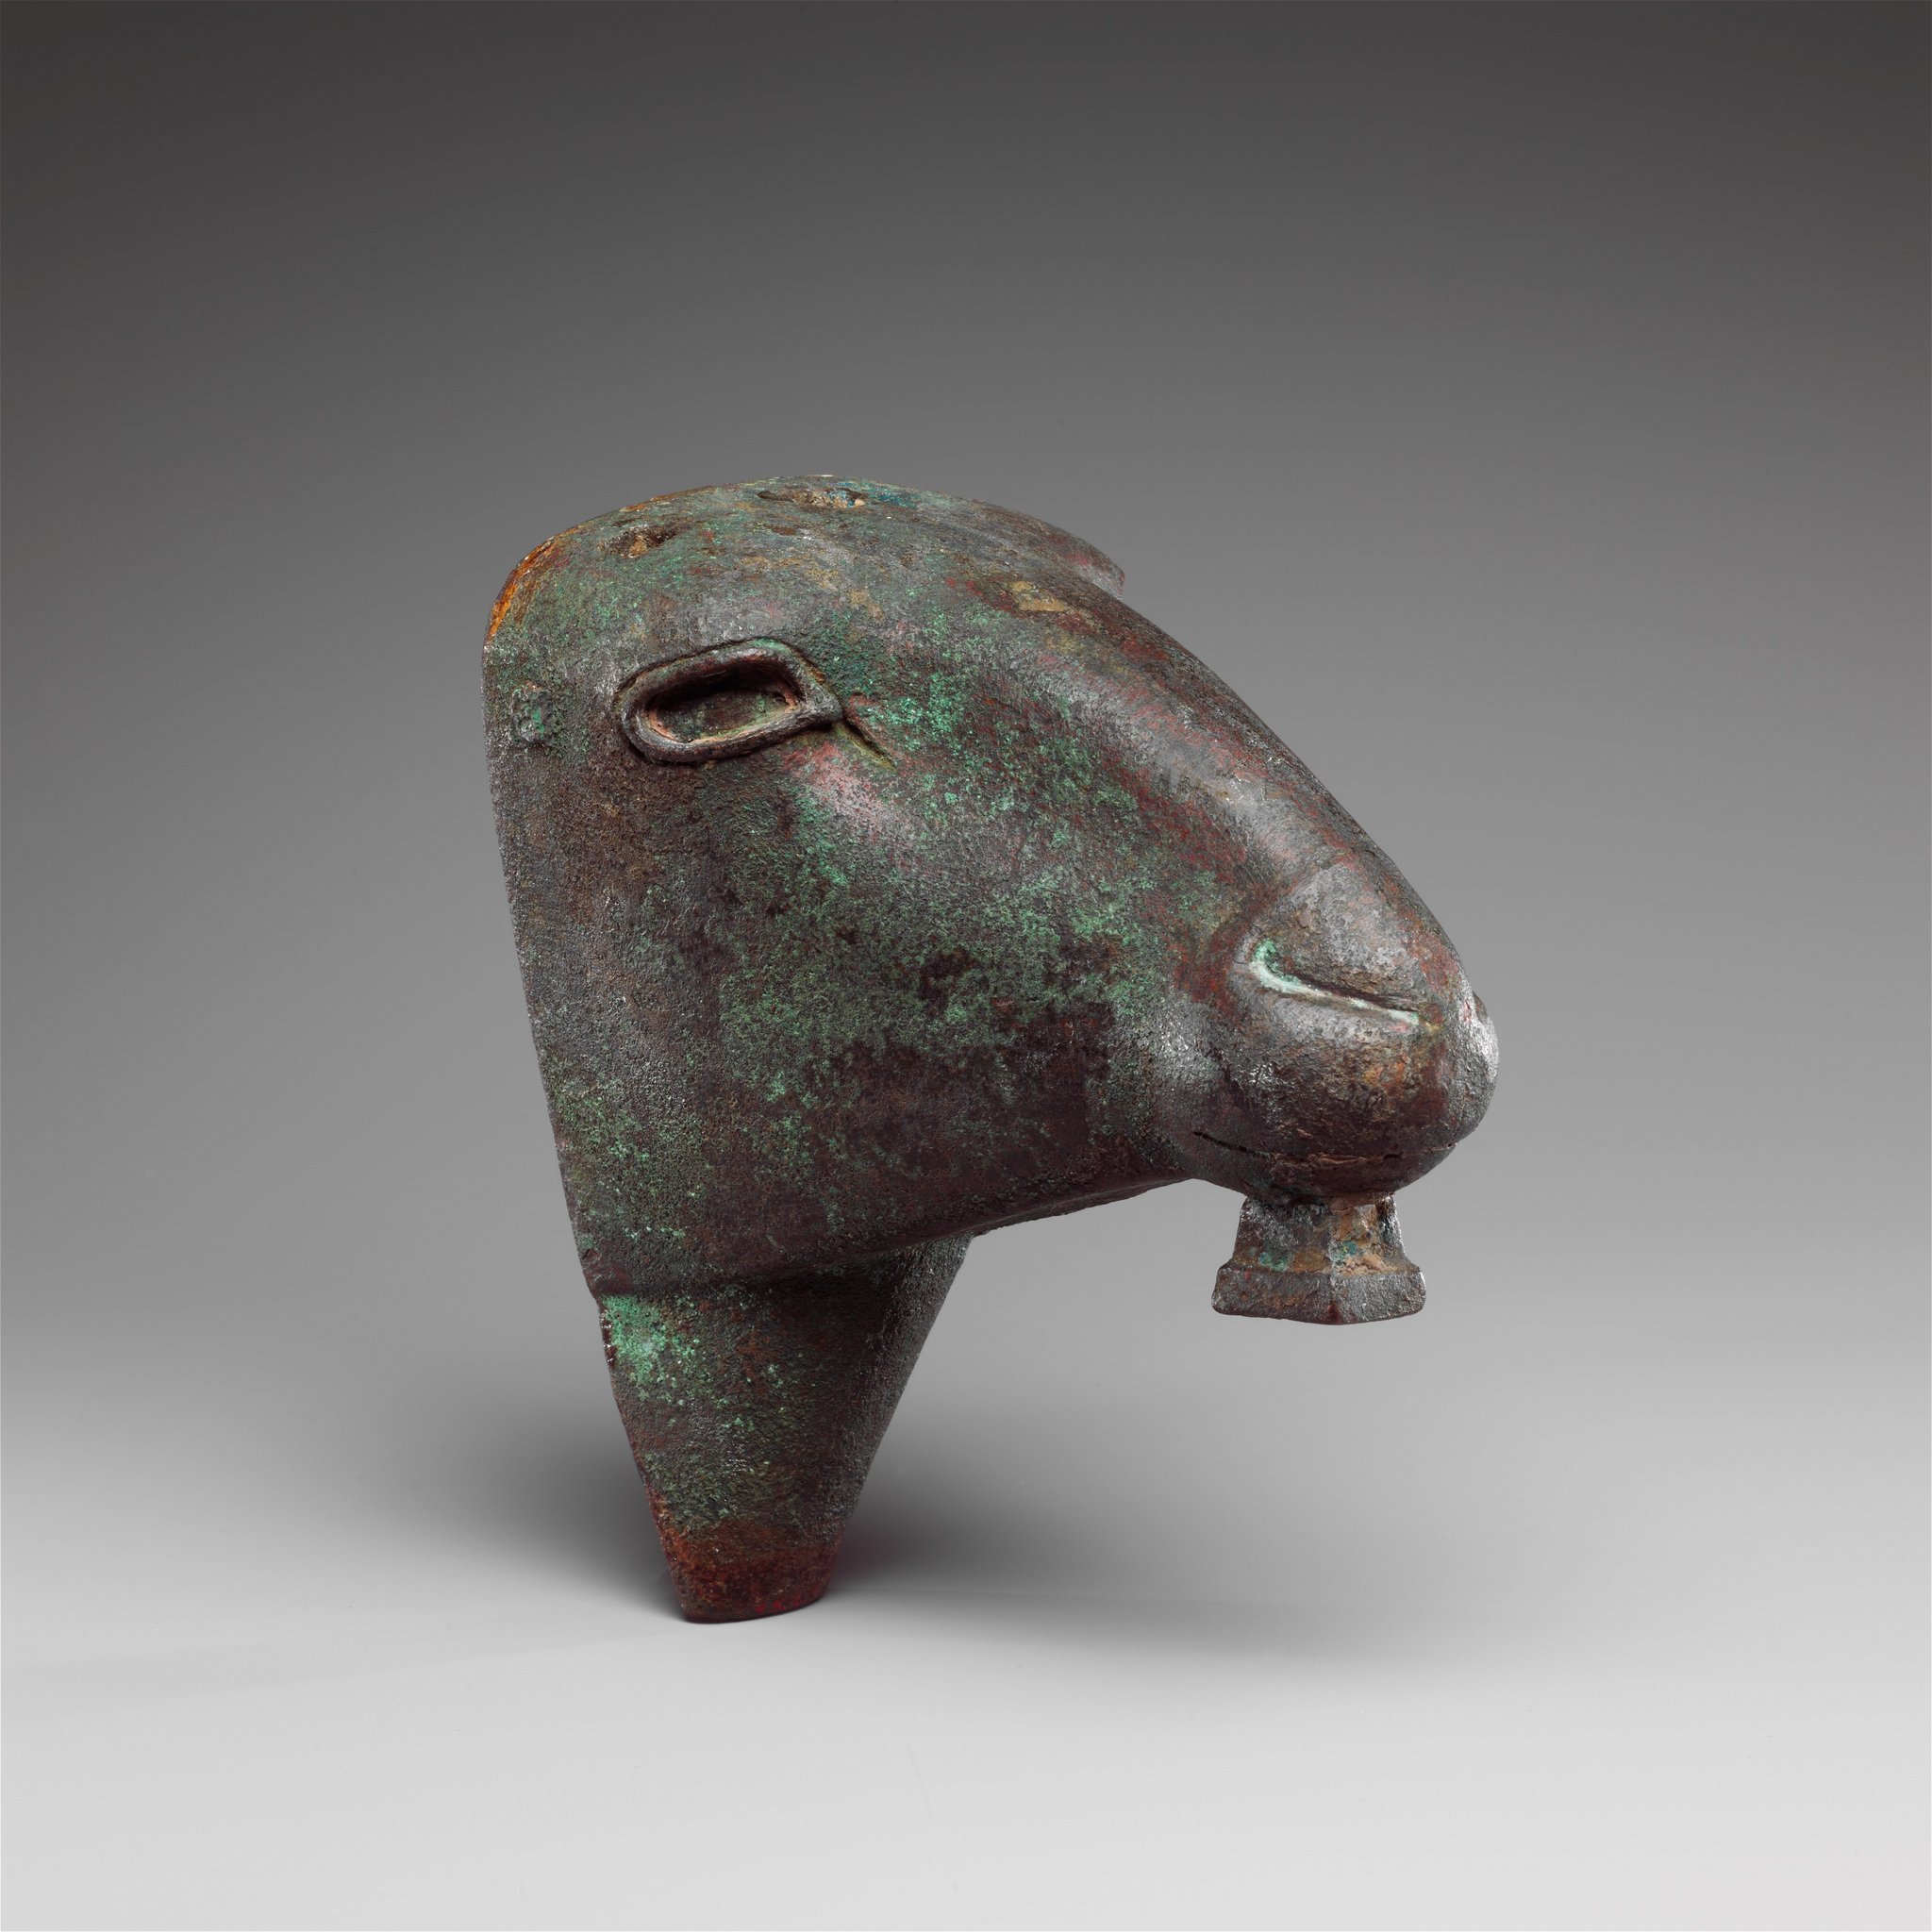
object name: statue attachment, ram head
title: Ram head made for attachment to a barque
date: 1070-664 BCE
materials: bronze, copper alloy, metal leaf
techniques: inlay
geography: egypt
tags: rams